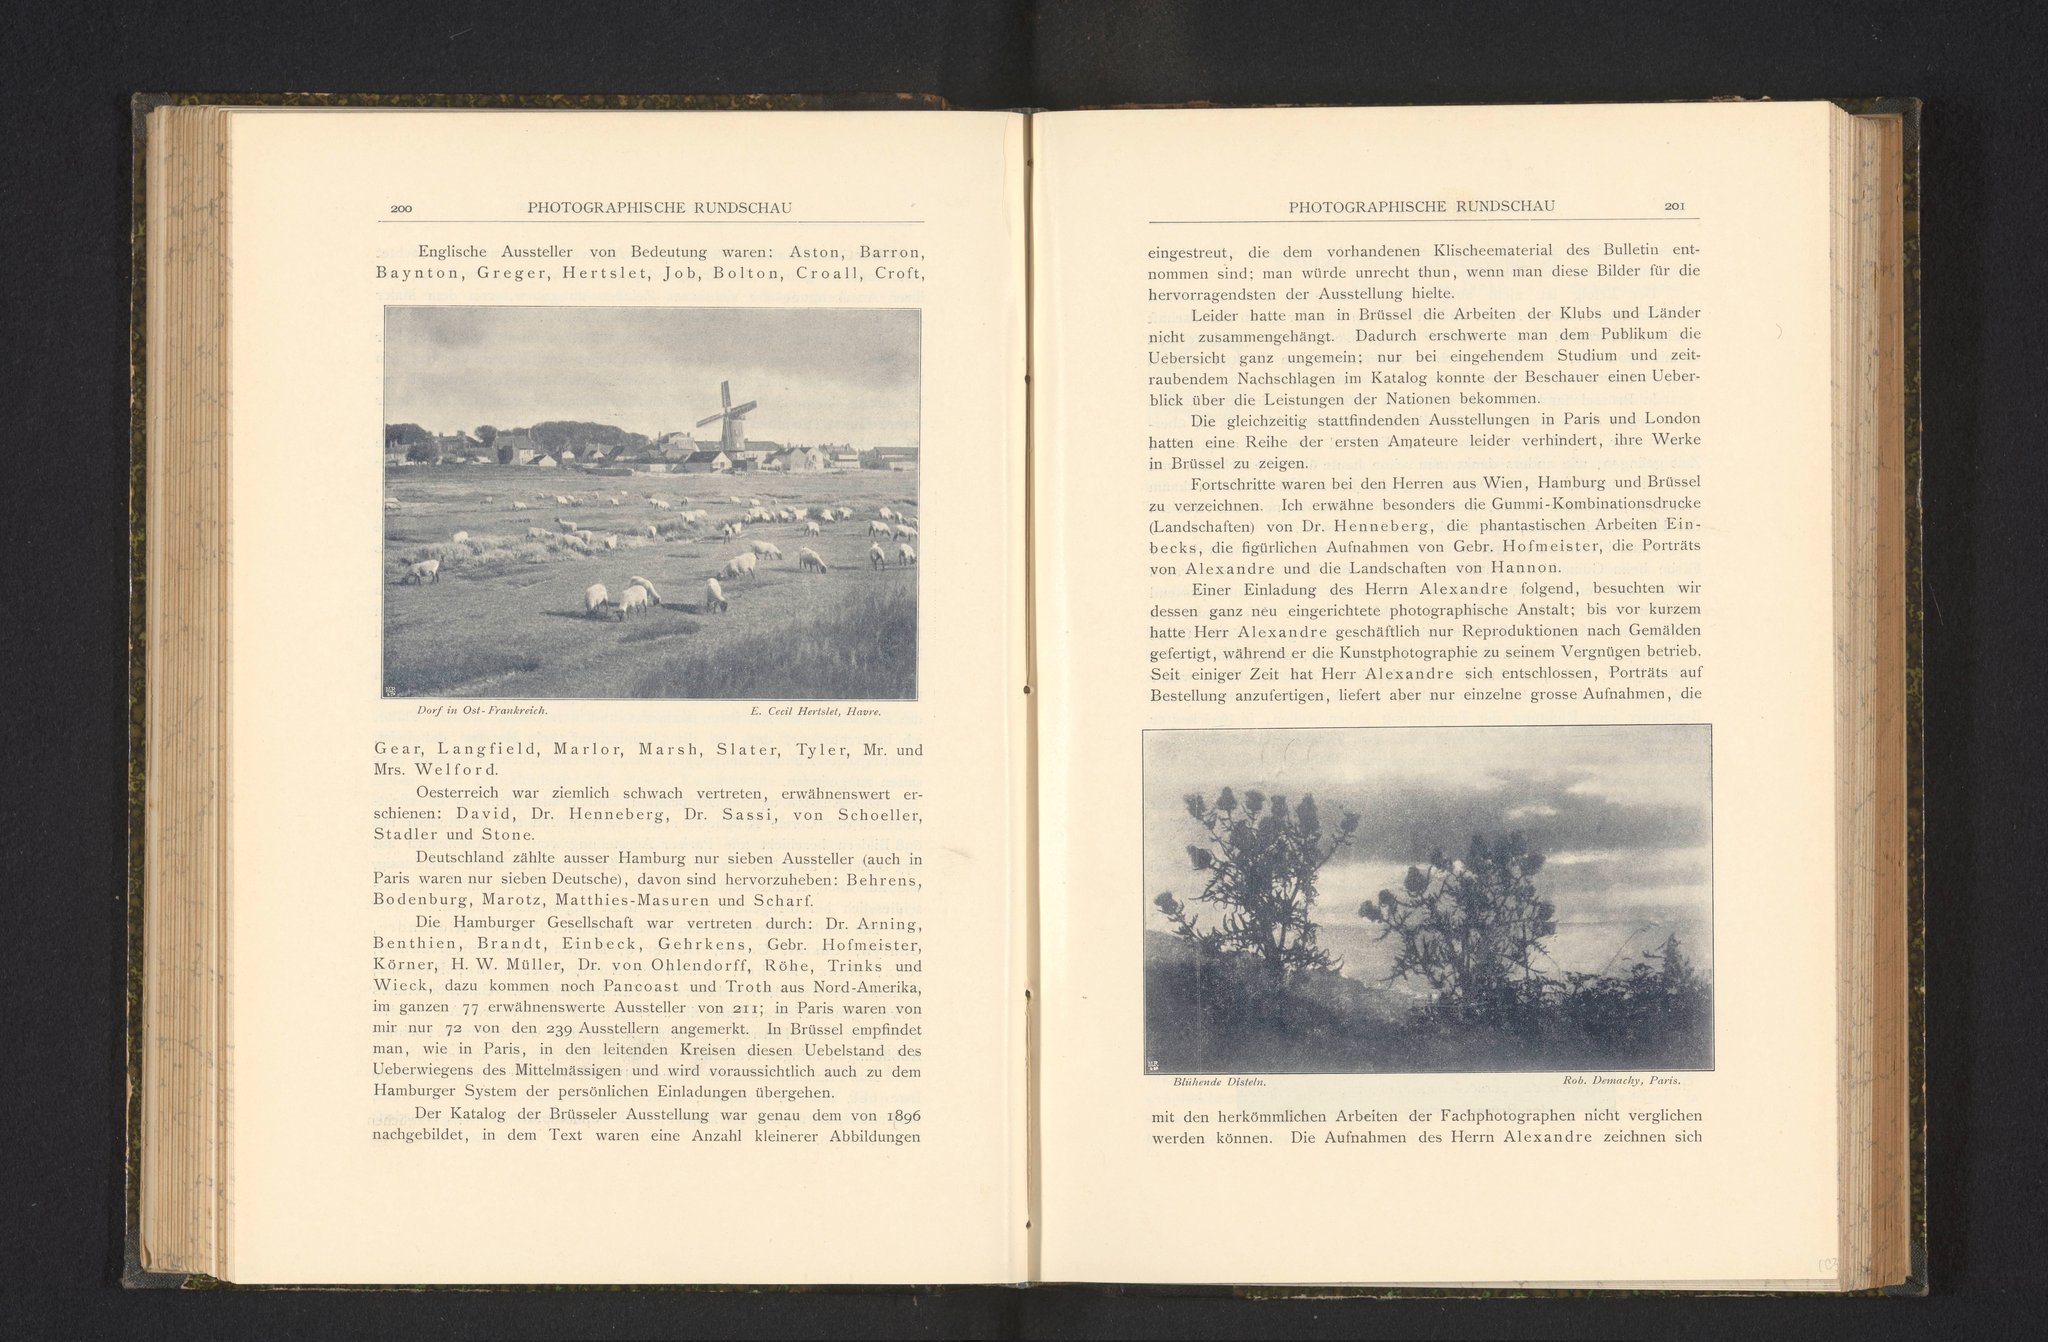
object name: photomechanical print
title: Schapenweide voor een dorp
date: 1893-1898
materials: paper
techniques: autotype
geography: france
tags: city-view in general; 'veduta', meadow, pasture, sheep